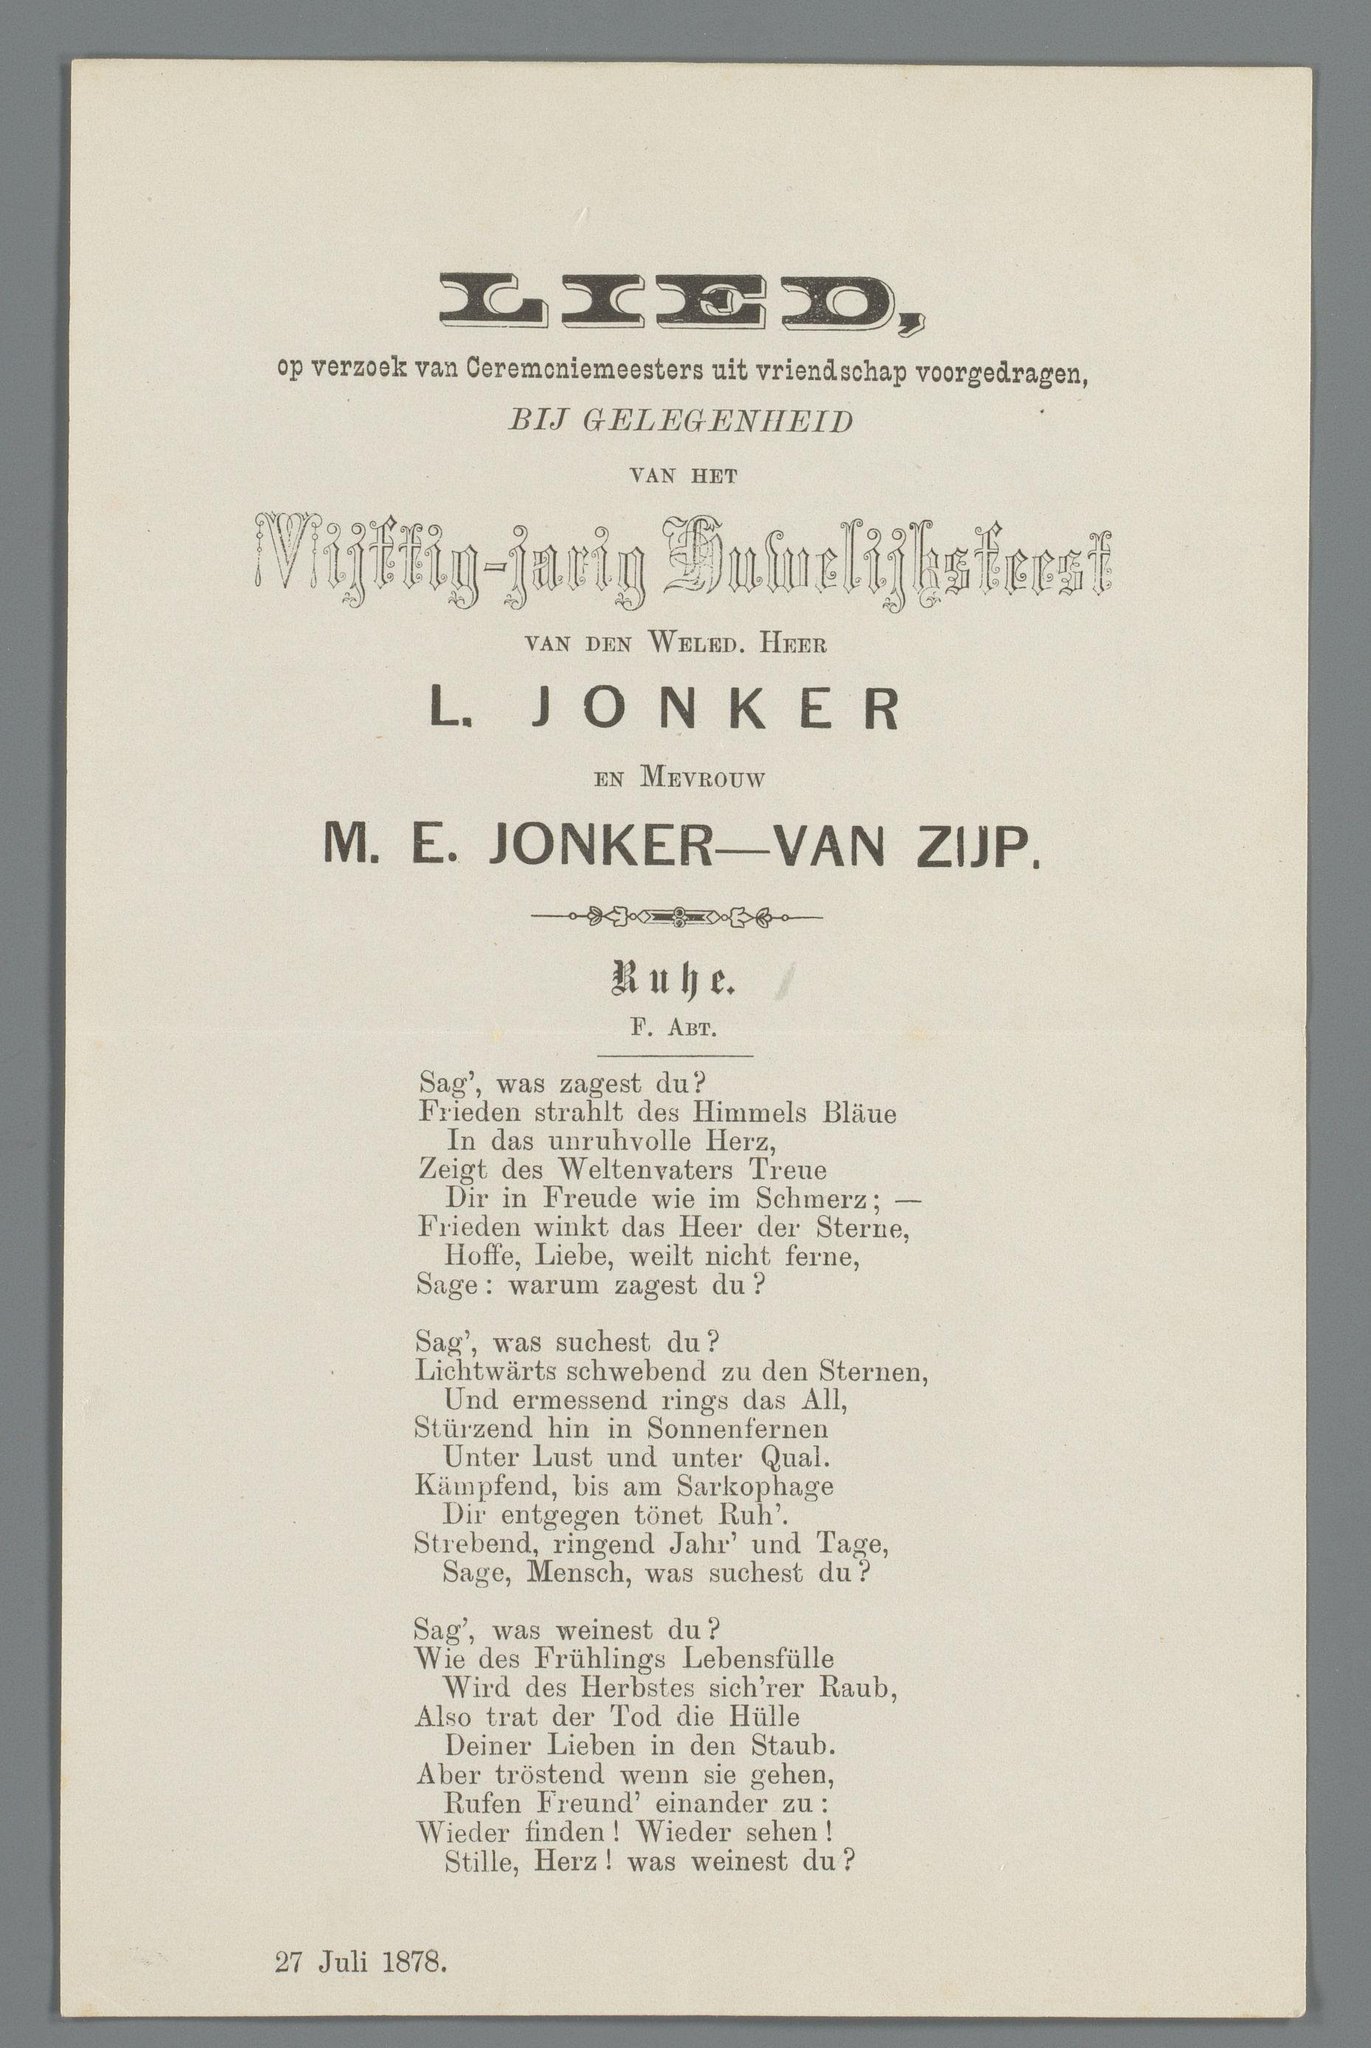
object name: text sheet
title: Ruhe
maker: Anonymous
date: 1878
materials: paper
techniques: letterpress printing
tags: marriage, married couple, 'matrimonium'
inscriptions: collector's mark: Lugt 2228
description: Eenzijdig bedrukt tekstblad met een Duitstalig lied.